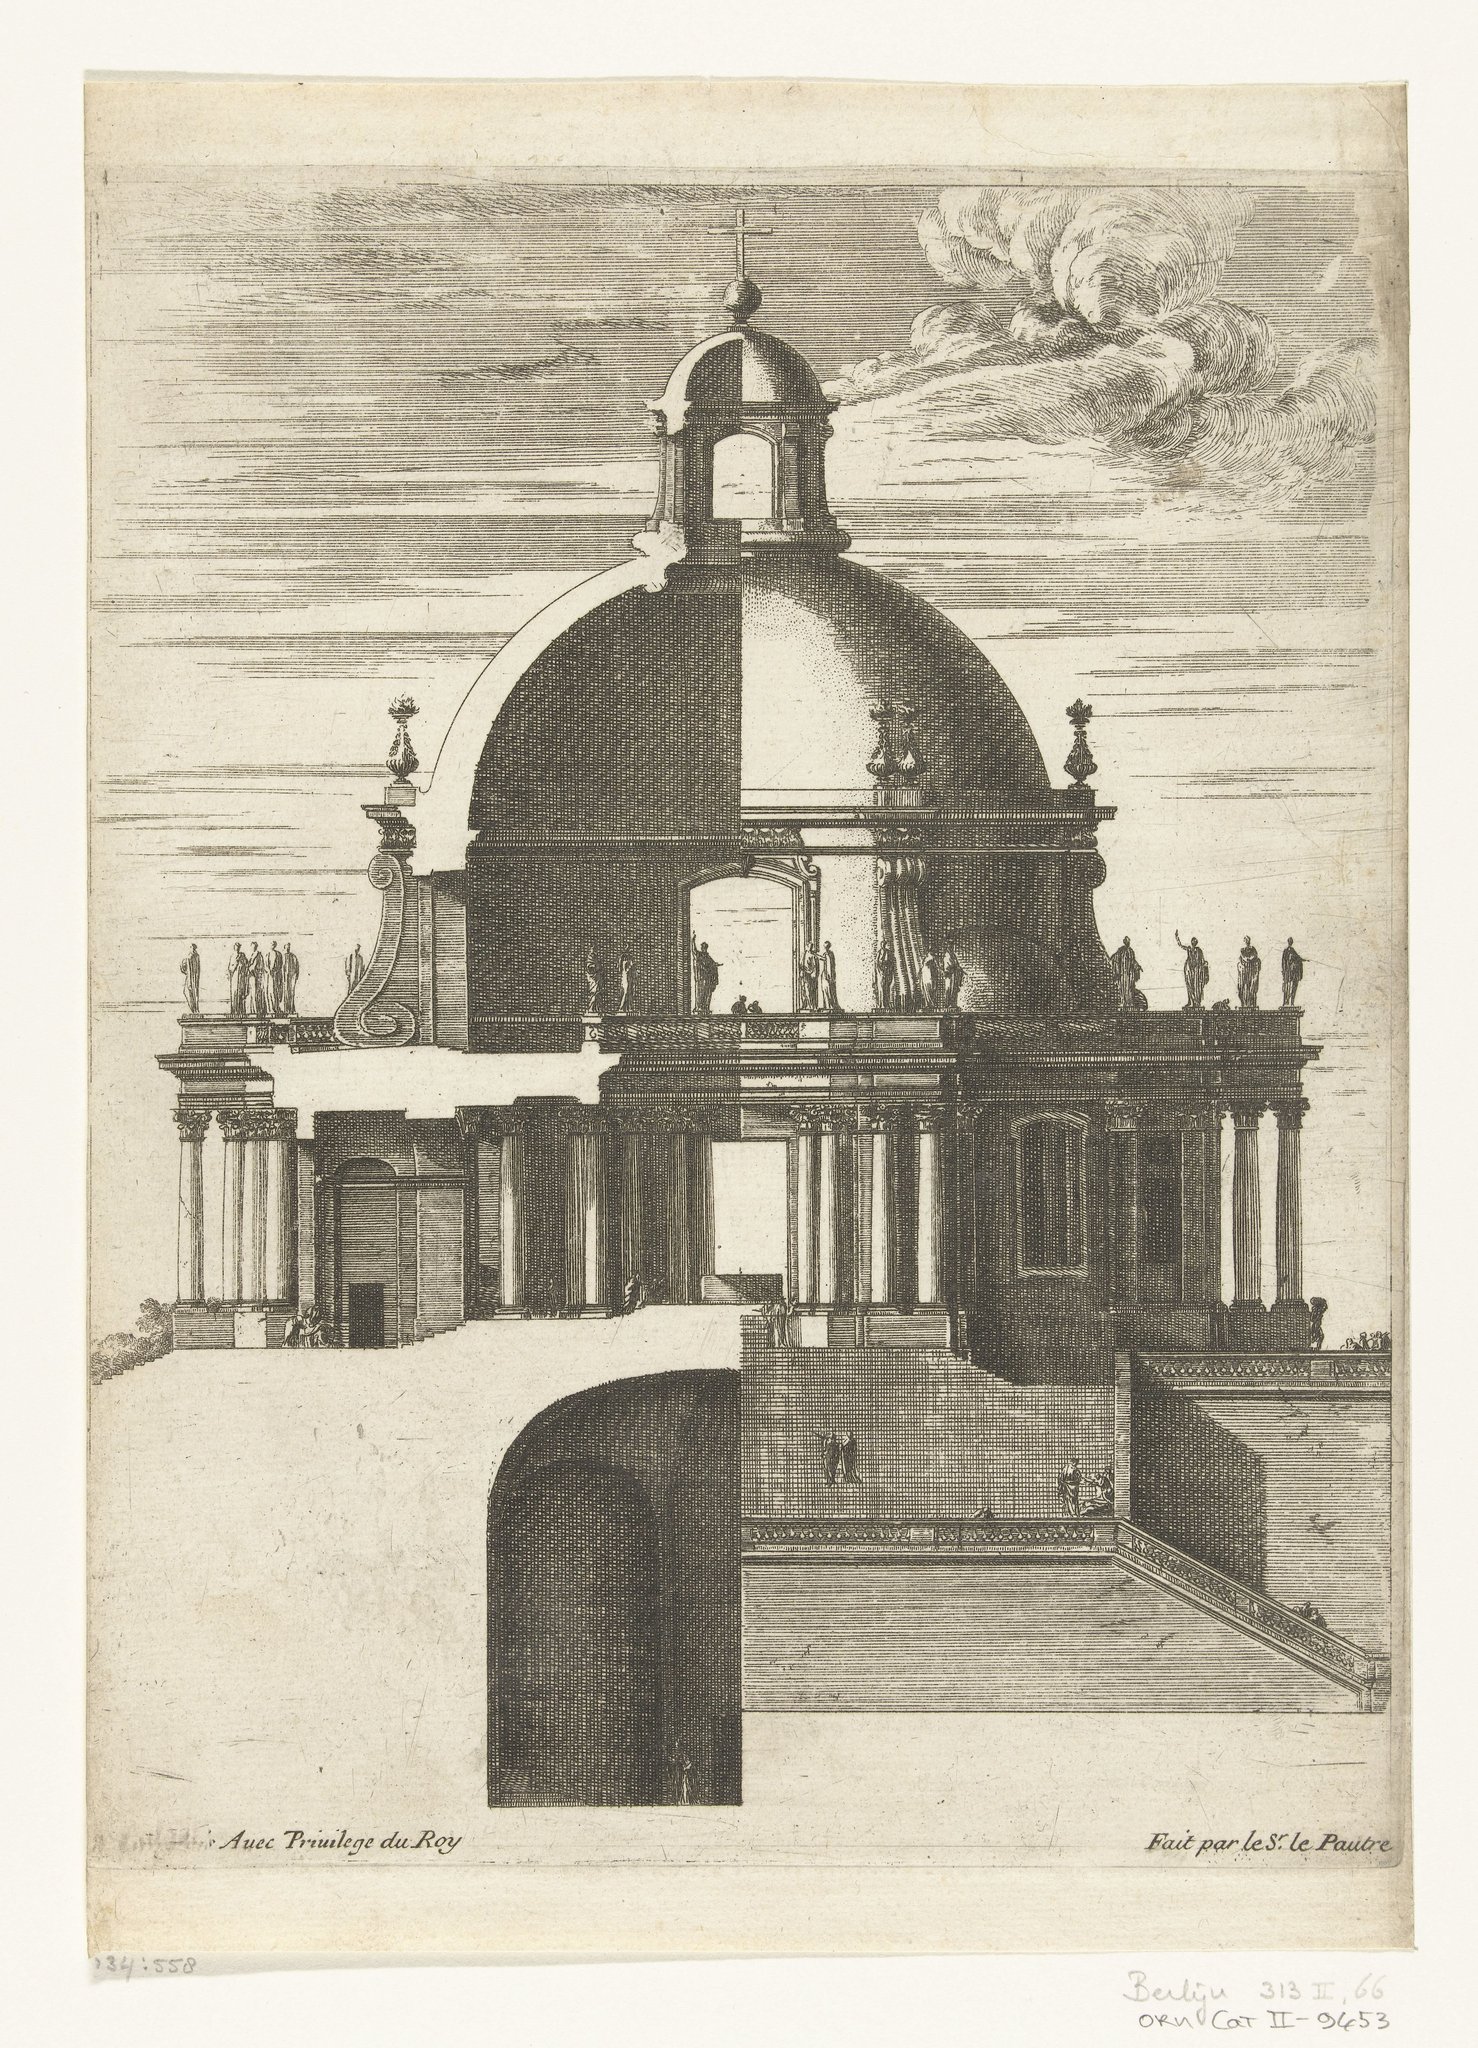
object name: ornament print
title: Kerkportieken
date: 1670-1680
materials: paper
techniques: etching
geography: paris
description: De kerk heeft vier portieken, elk met dubbele Korintische zuilen; links een doorsnede met de crypte, rechts de opstand van de gevel.